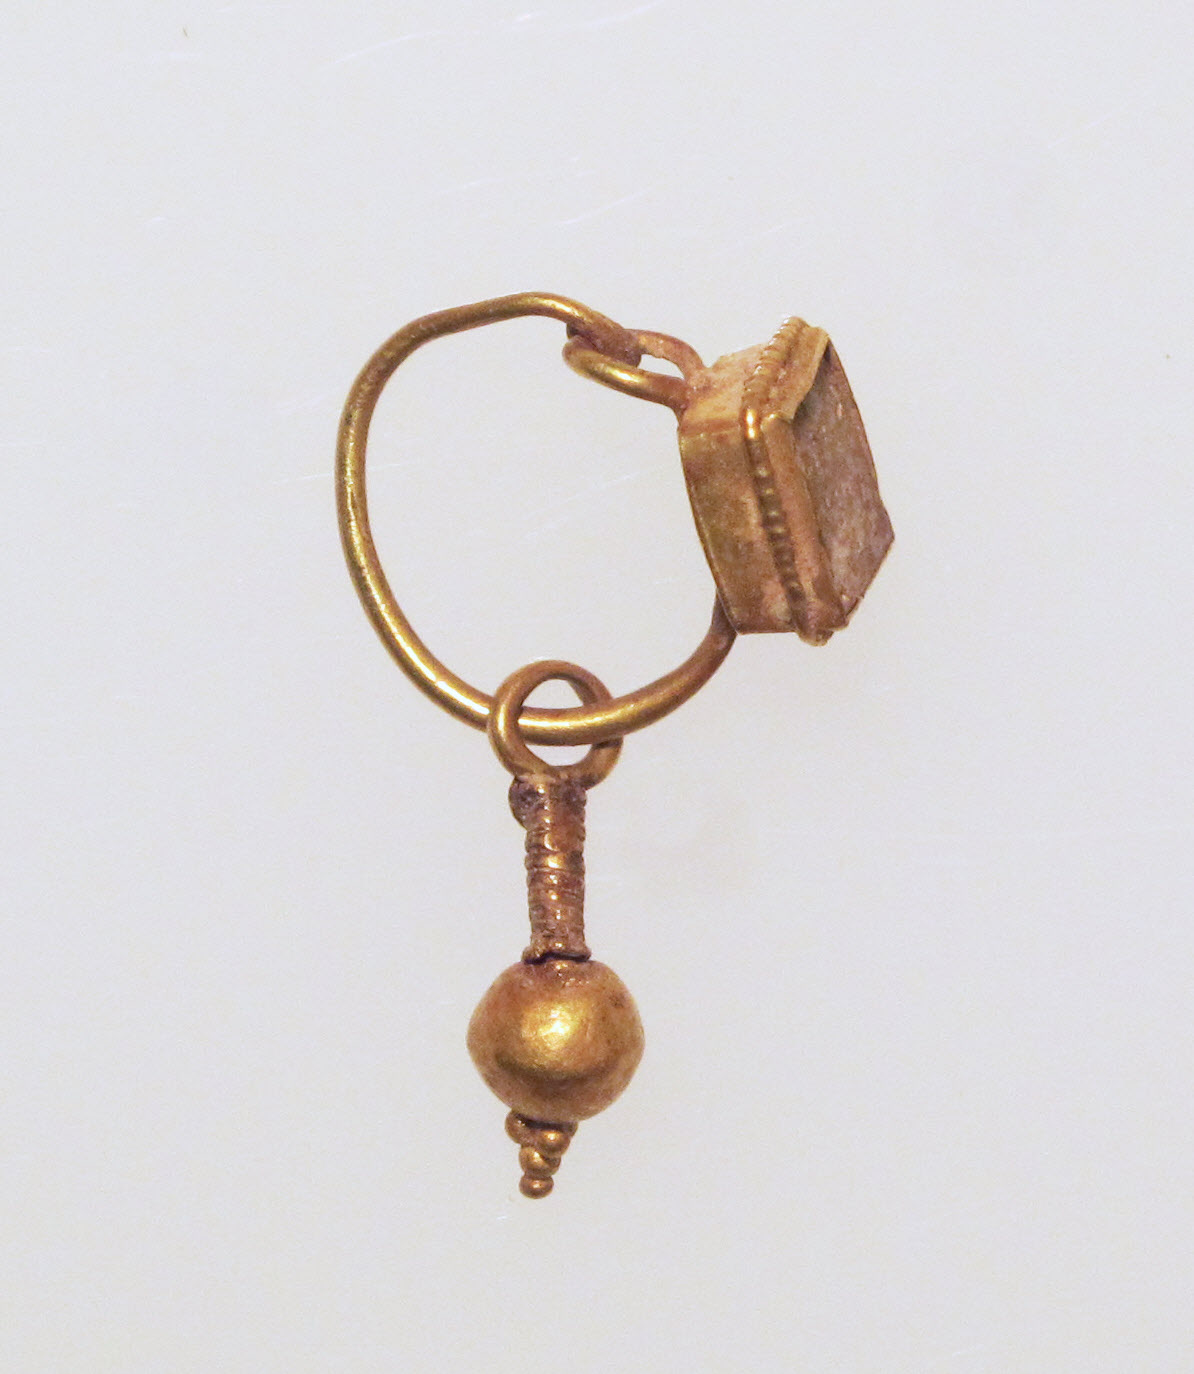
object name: earring with pendant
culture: roman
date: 670 BCE-330 CE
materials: gold